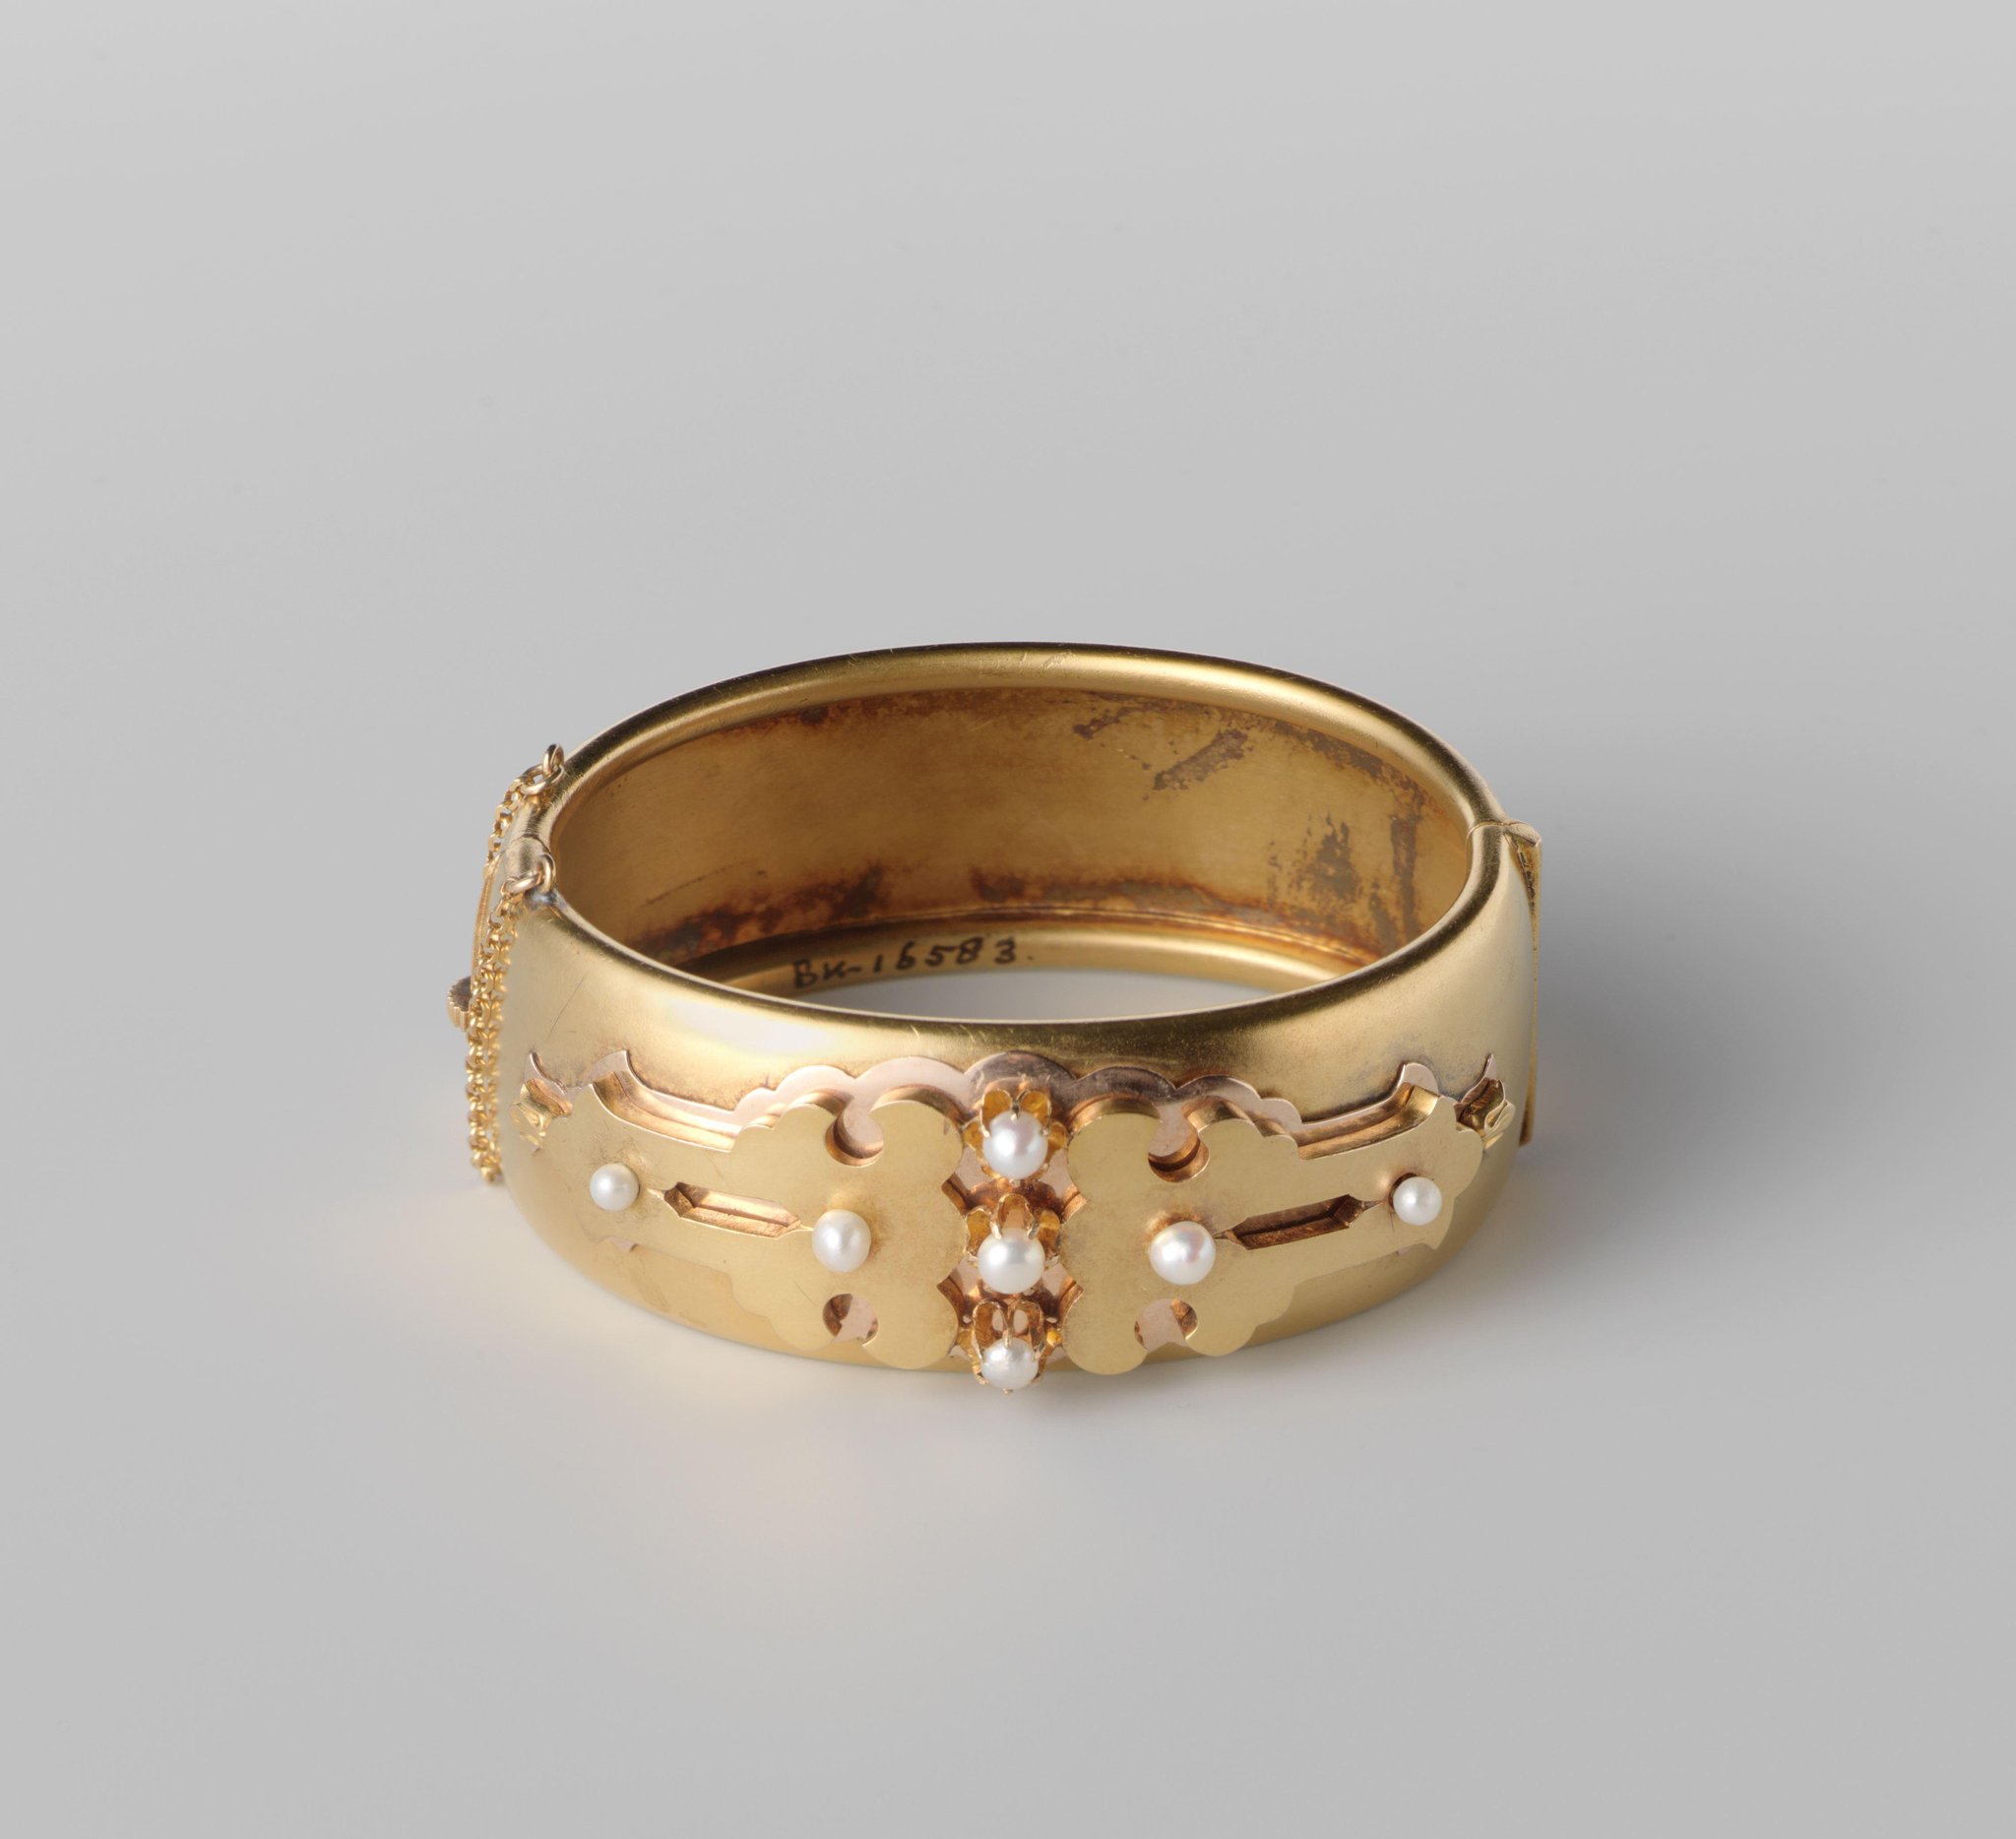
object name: bracelet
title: Armband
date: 1800-1900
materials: gold, pearl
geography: germany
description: Brede armband van dof goud. Met een opgelegde versiering, waarin zeven parels.